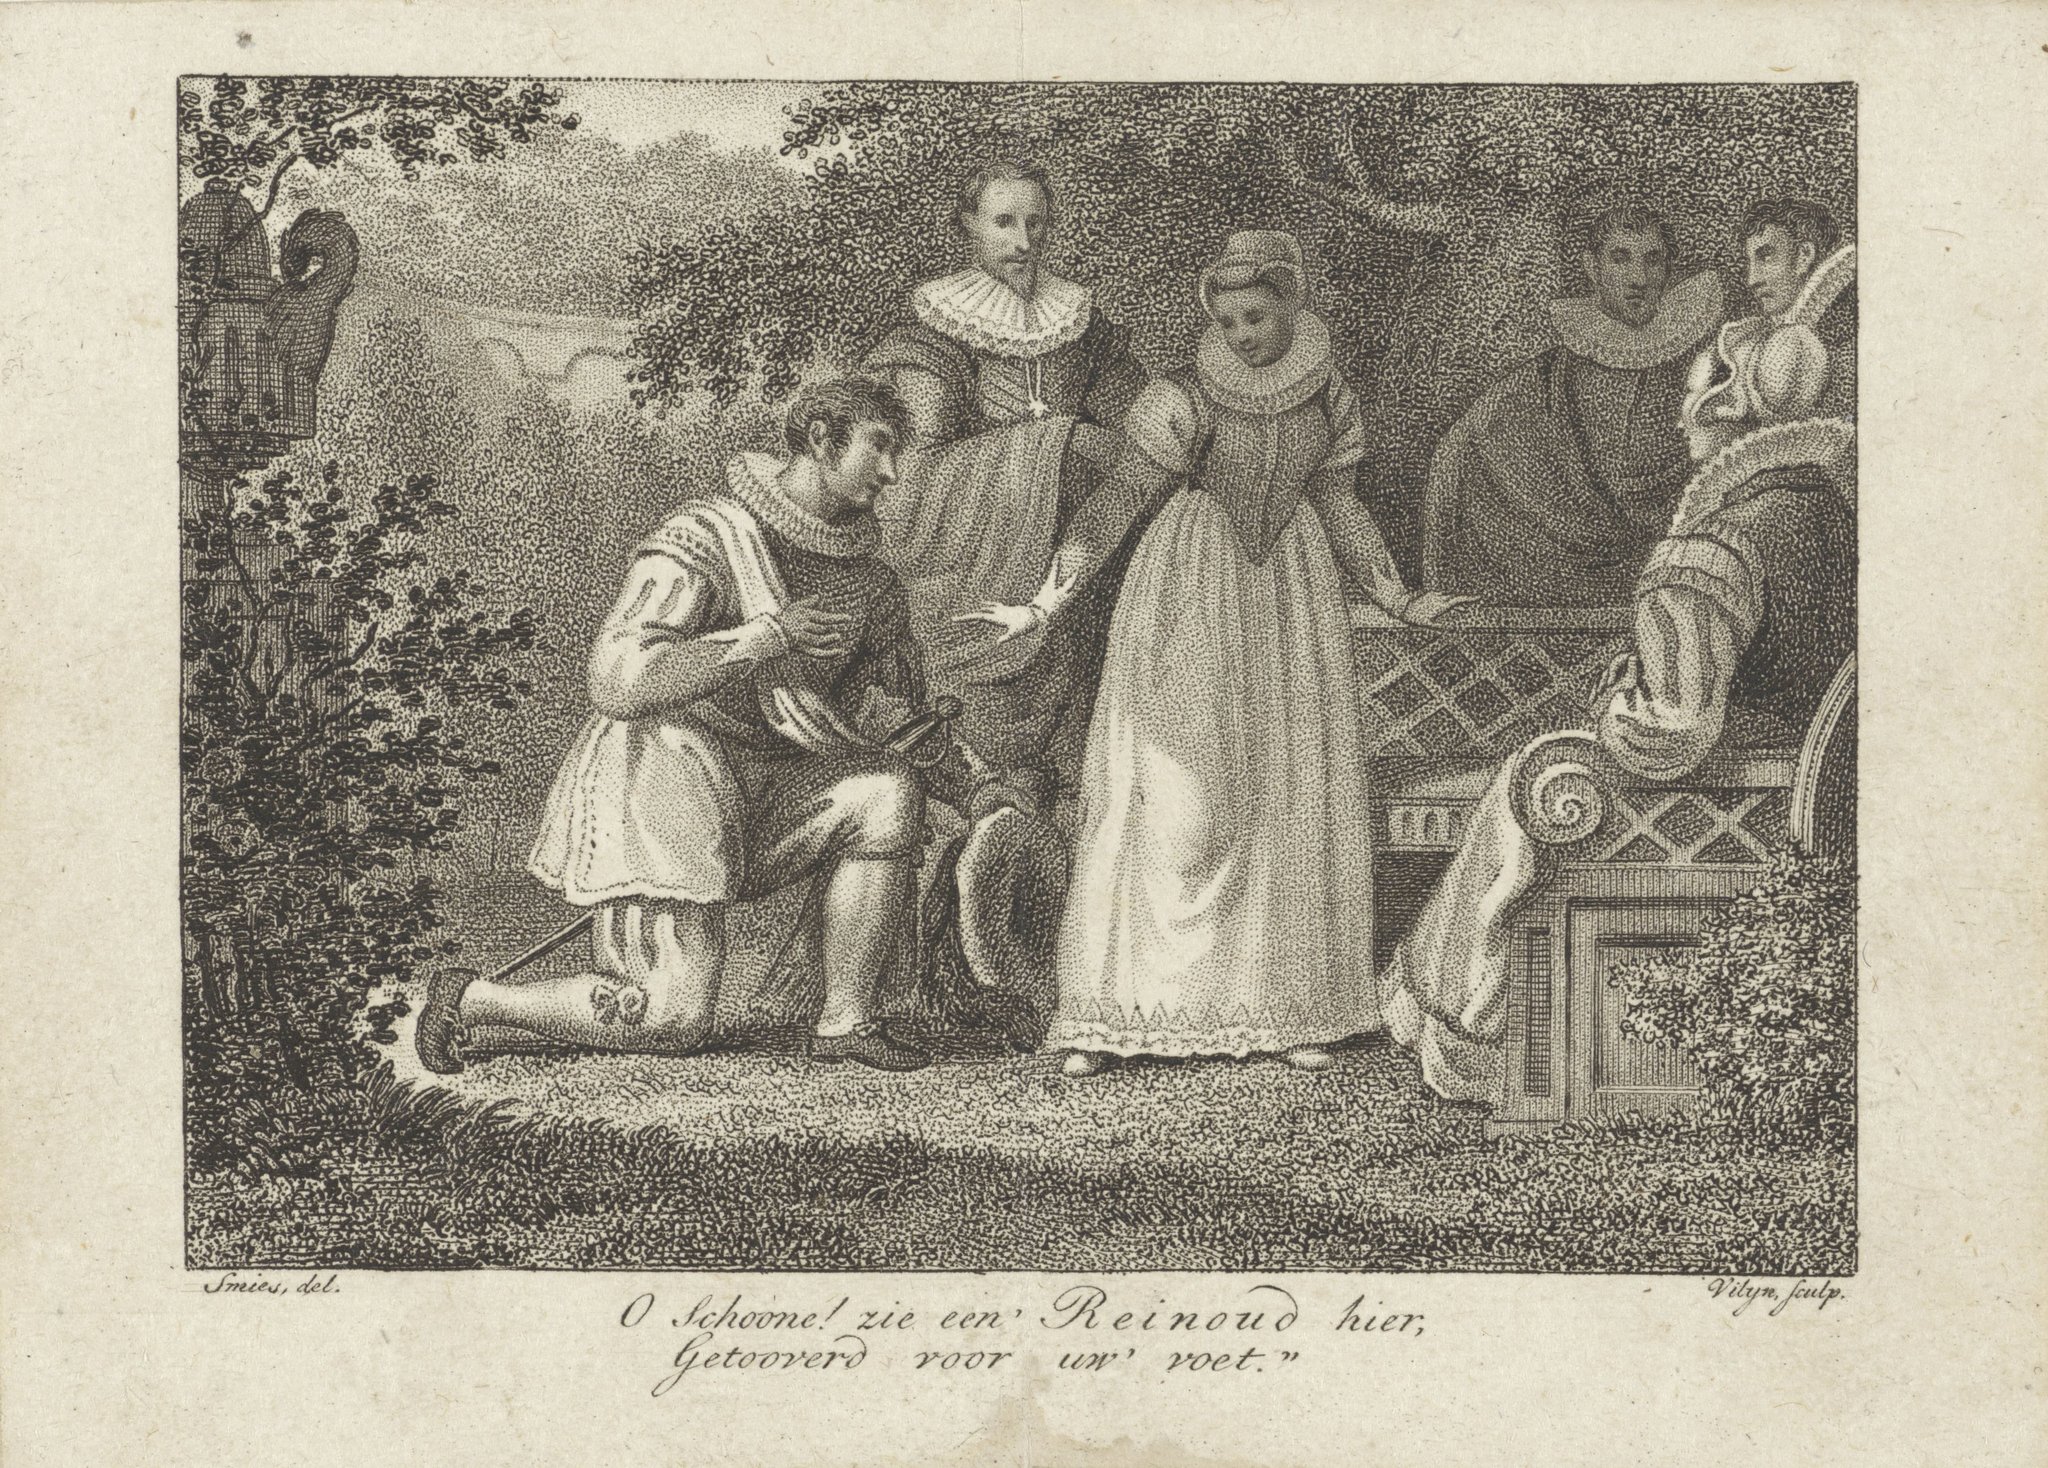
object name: print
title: Knielende man bij een vrouw bij een tuinbank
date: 1811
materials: paper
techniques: engraving, etching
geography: netherlands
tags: garden, man kneeling before his beloved (proposing)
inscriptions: collector's mark: Lugt 2228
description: Prent ook gebruikt als boekillustratie in: Almanak van vernuft en smaak voor het jaar 1811. Amsterdam: weduwe J. Dóll, 1811.